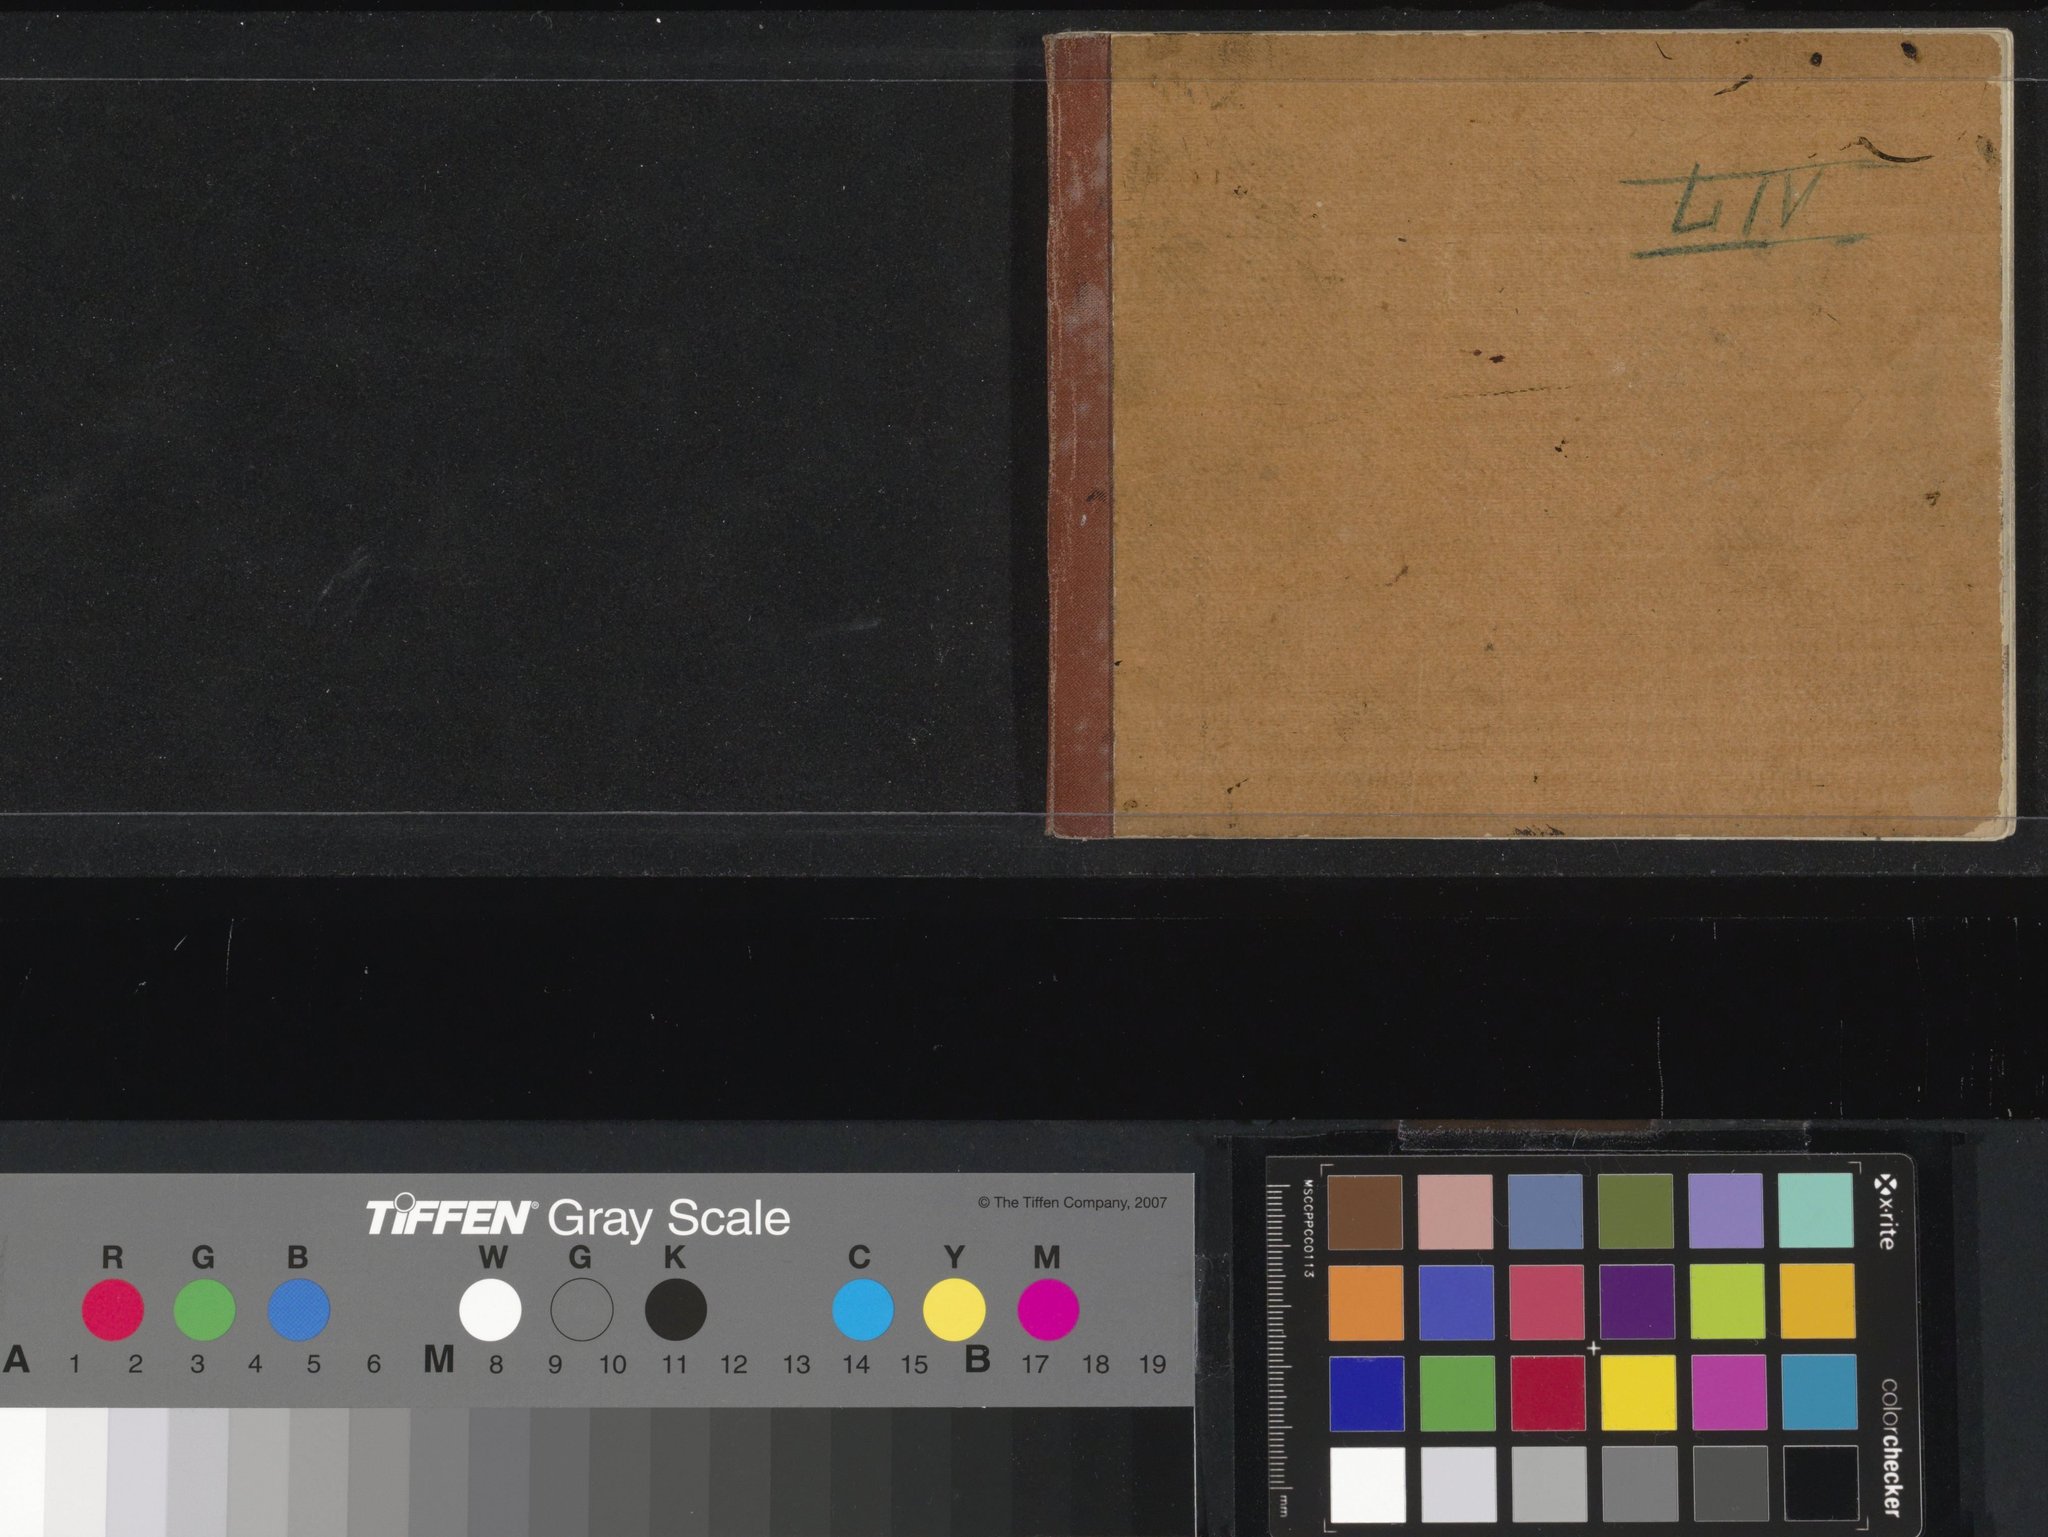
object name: sketchbook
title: Schetsboek LIV met 18 bladen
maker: isaac israels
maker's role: draughtsman, painter, print maker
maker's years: 1865-1934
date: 1886-1934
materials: cardboard, chalk, linen, paper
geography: amsterdam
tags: maid ~ house personnel, street (+ city(-scape) with figures, staffage)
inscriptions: collector's mark: Lugt 2228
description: Bladen 1(V) t/m 1A(V), 2(V) t/m 4(R), 5(V), 8(V), 9, 11(V) t/m 13(R), 16(V) t/m 18(R) en het voorste schutblad A zijn blanco en daarom niet beschreven.